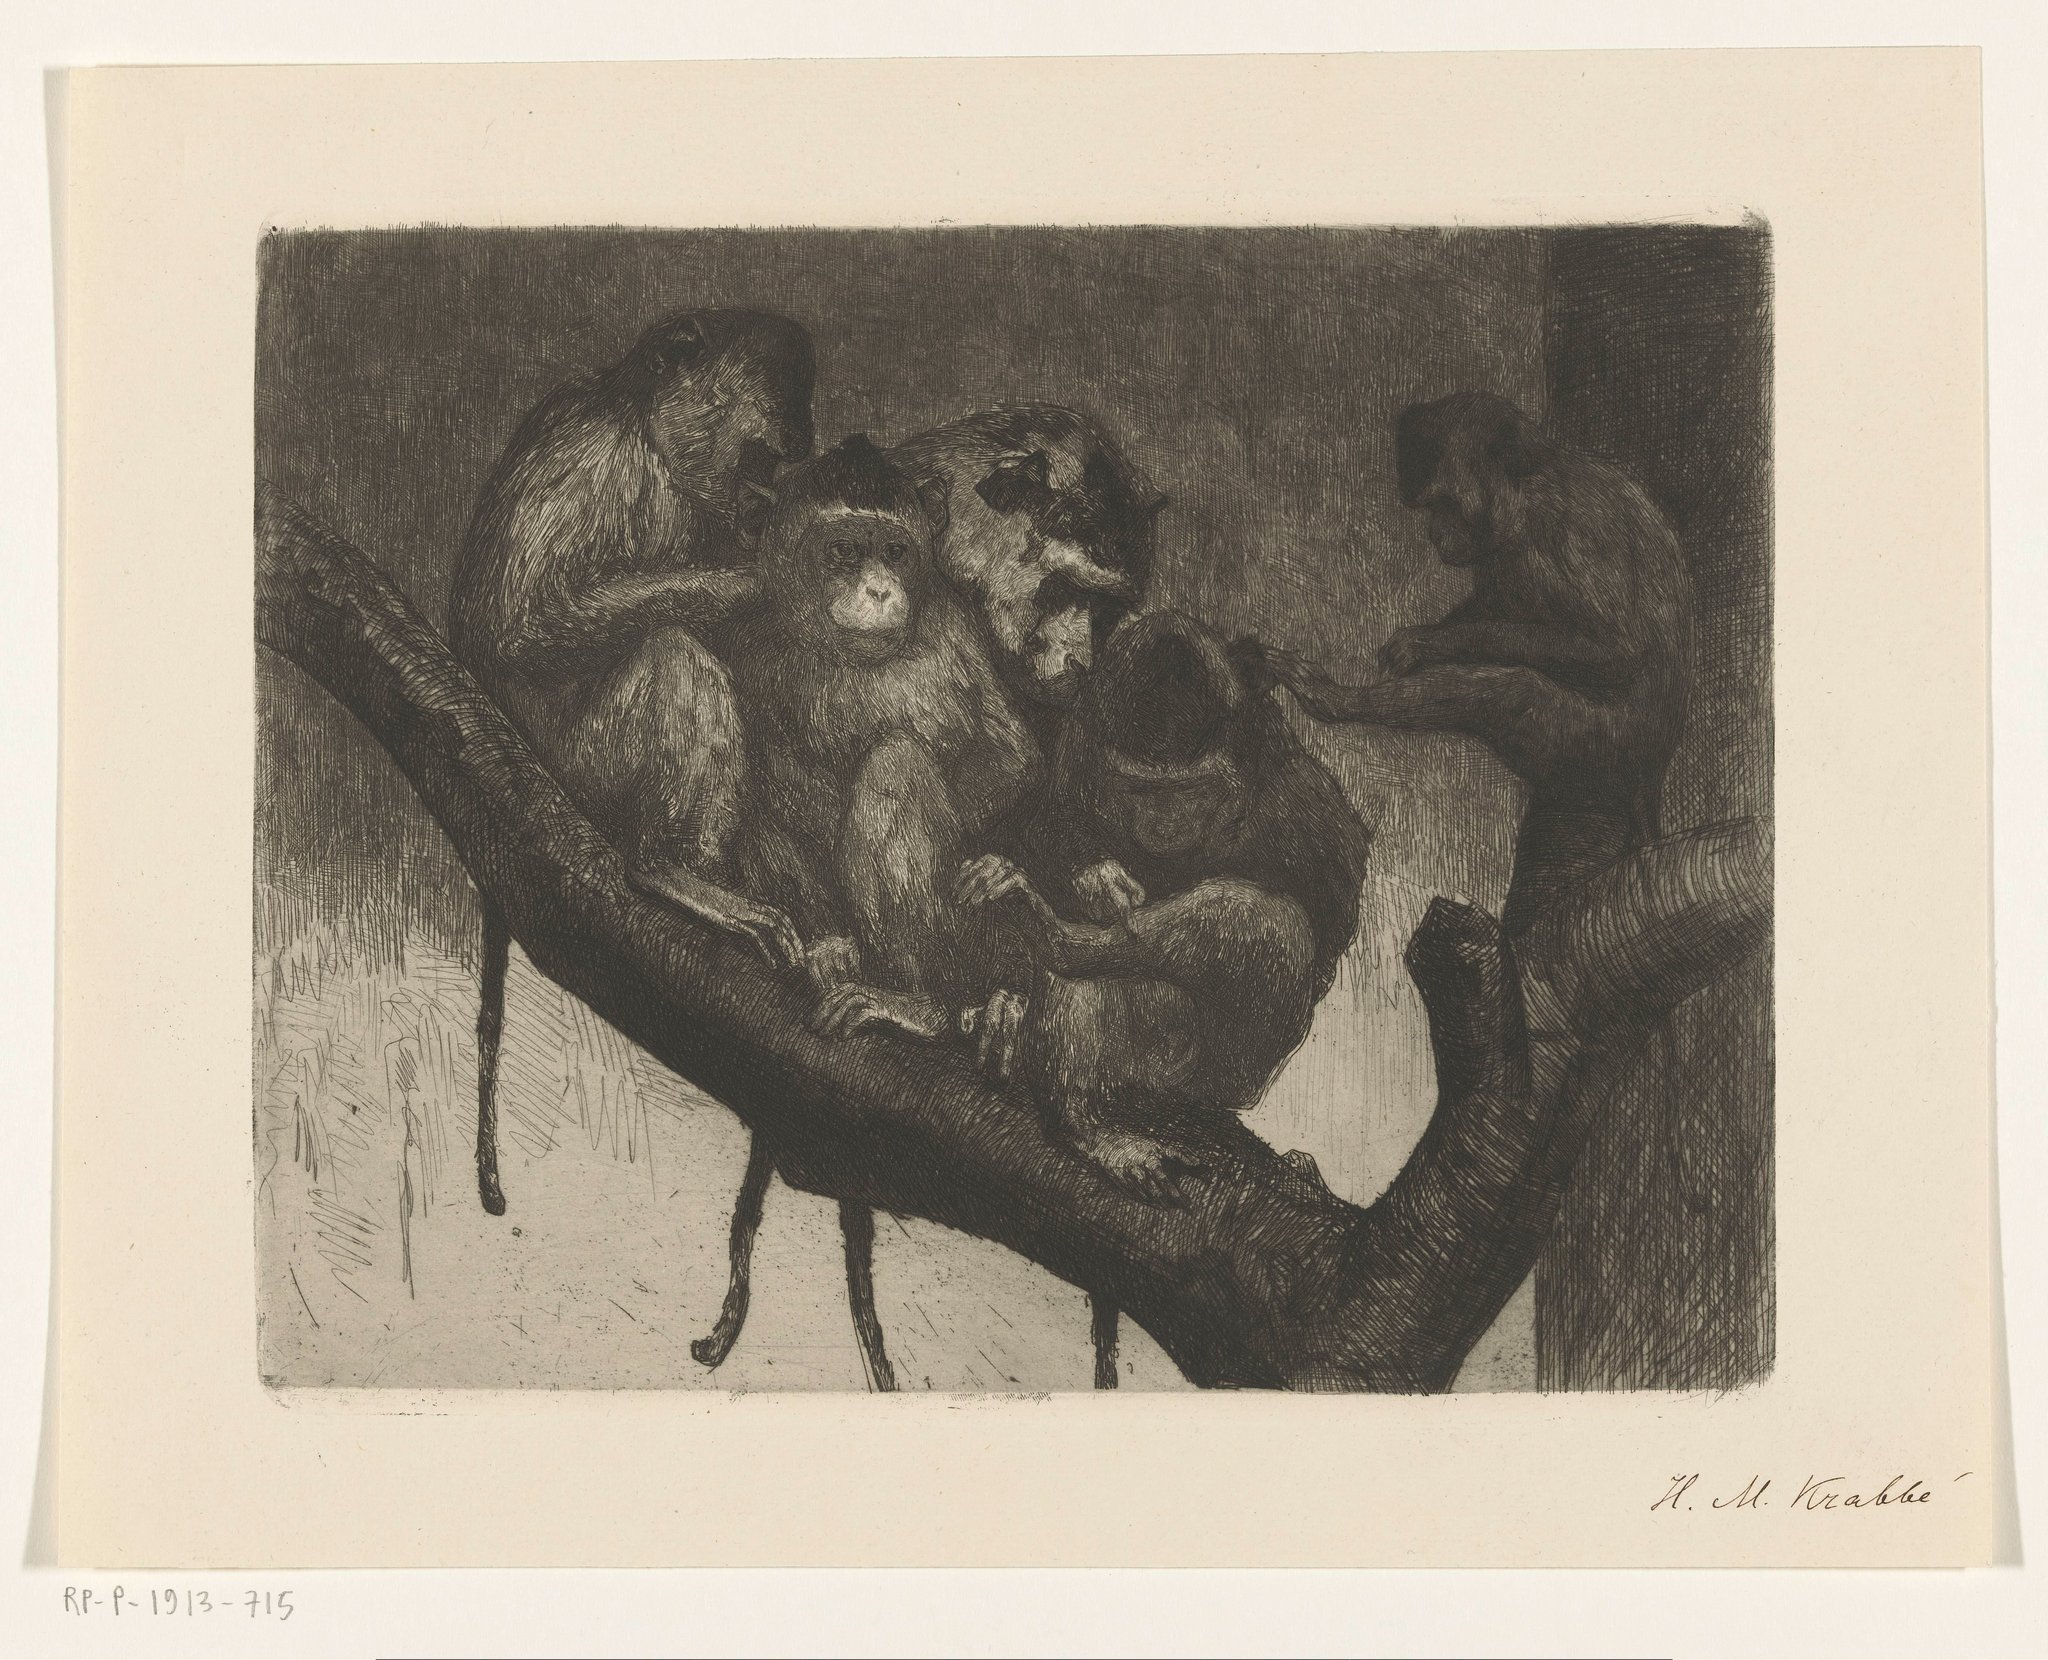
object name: print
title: Vijf apen in een boom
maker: heinrich m. krabbé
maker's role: draughtsman, print maker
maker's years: 1868-1931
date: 1878-1913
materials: paper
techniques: etching, intaglio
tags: monkeys, apes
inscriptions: collector's mark: Lugt 2233